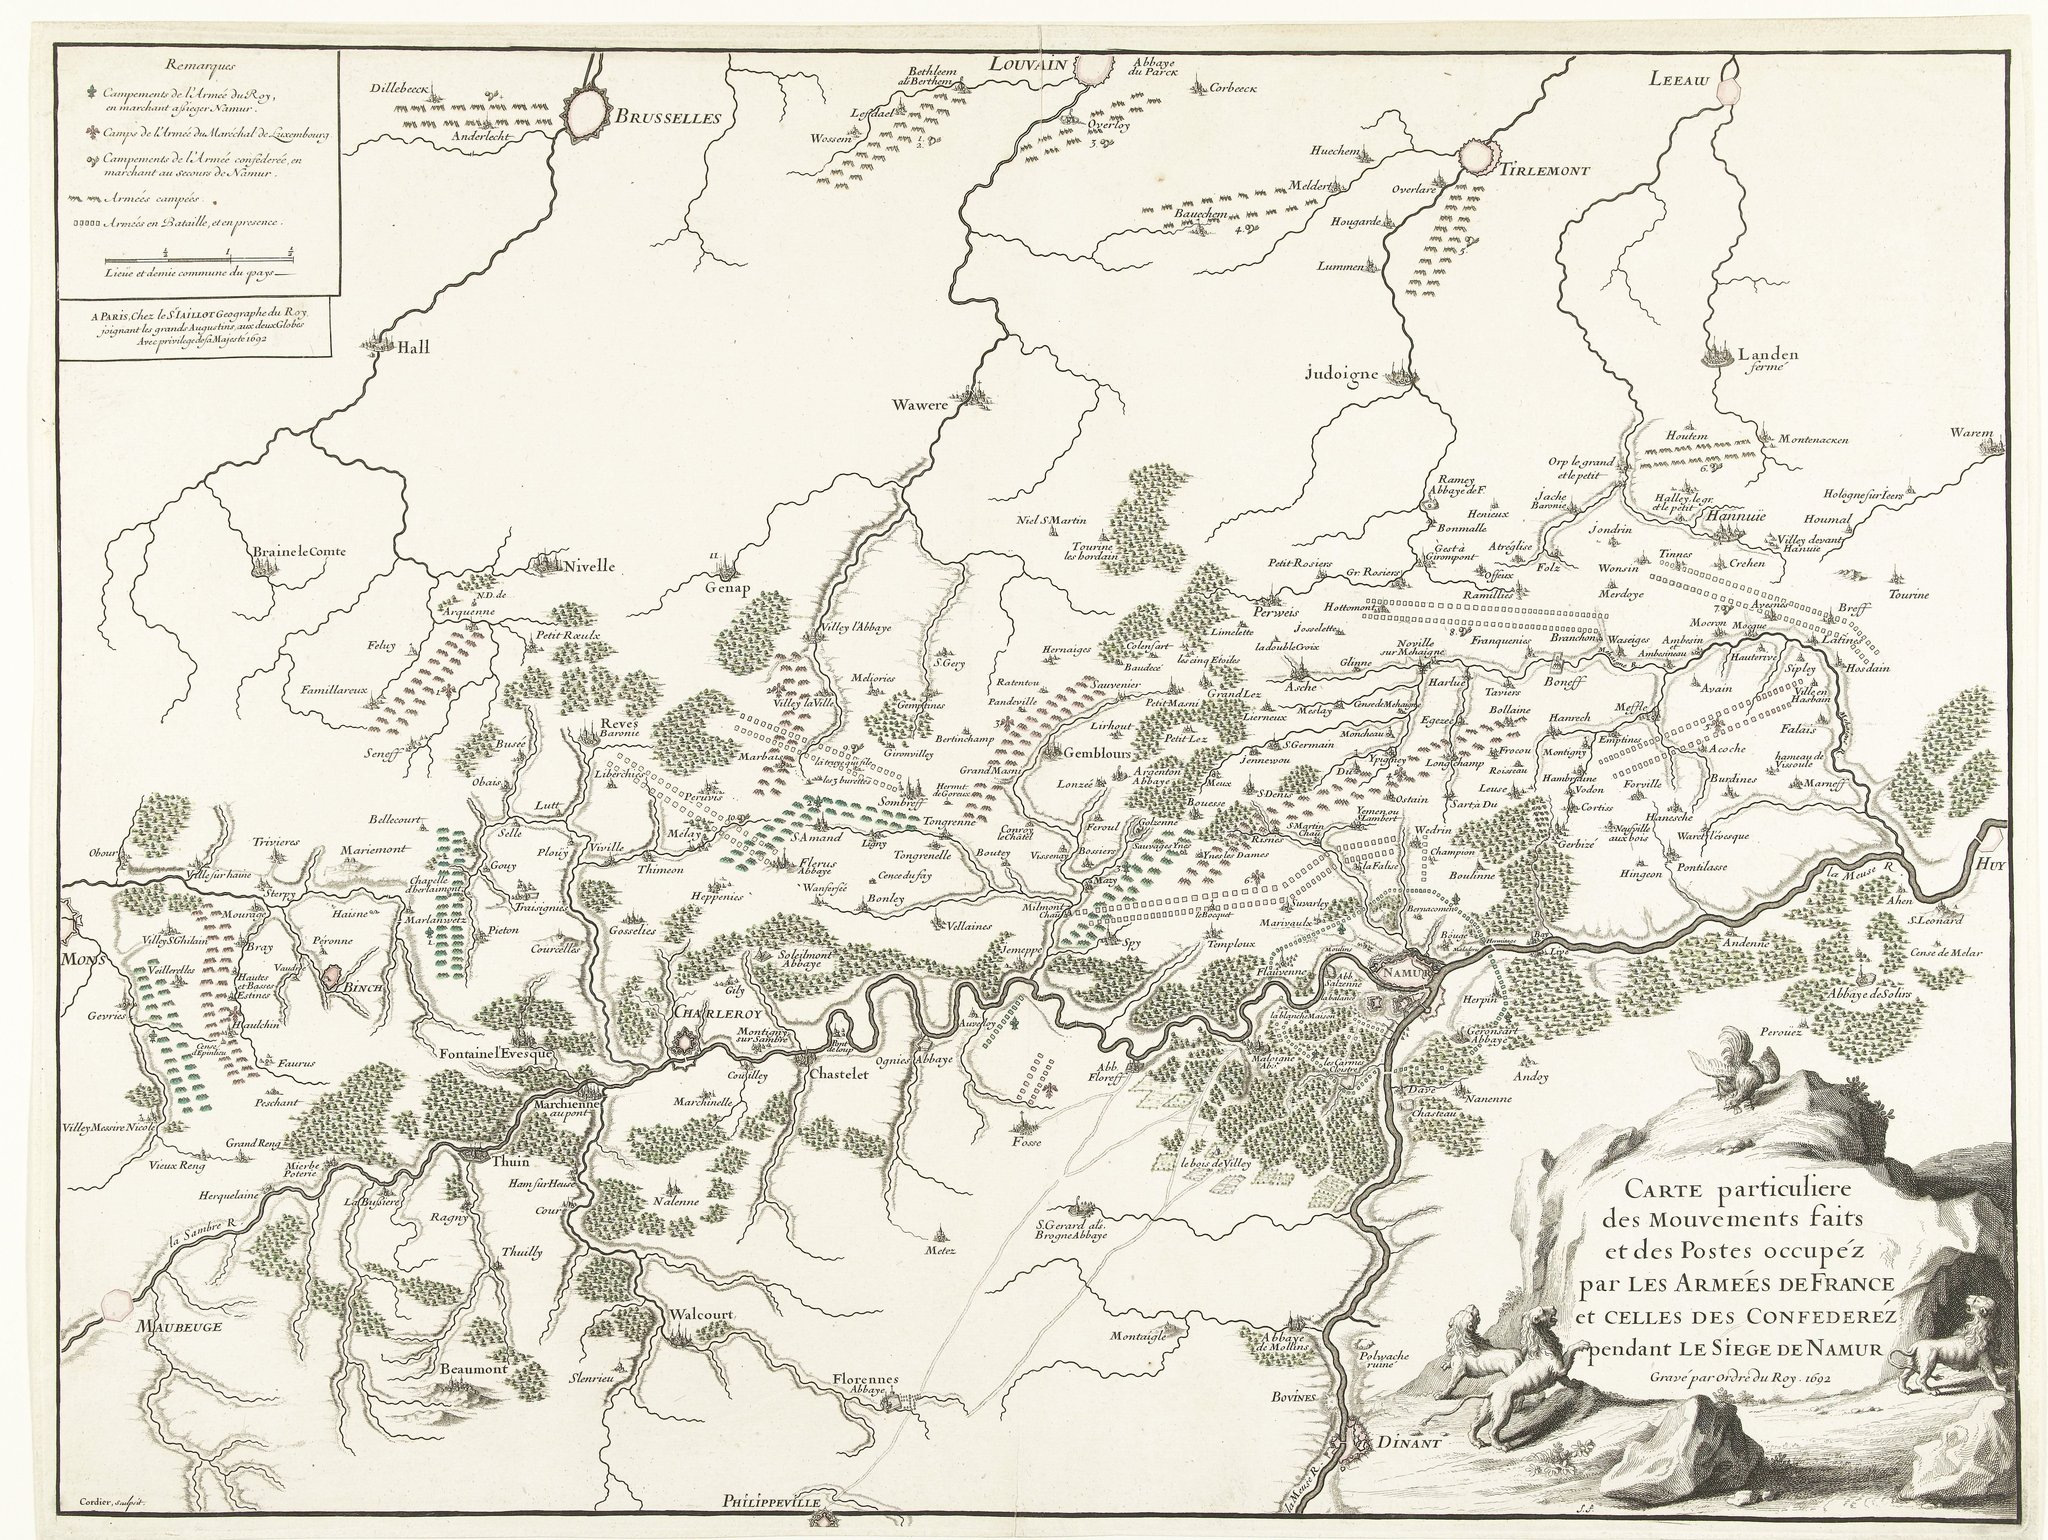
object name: map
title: Carte particuliere des Mouvements faits et des Postes occupéz par les Armées de France et celles des Confederez pendant Le Siege de Namur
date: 1692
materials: paper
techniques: etching, hand coloring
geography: paris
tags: siege, position war, maps of cities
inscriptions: date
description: Kaart van het gebied rond de stad Namen, belegerd door het Franse leger, 25 mei - 30 juni 1692. In de kaart de legerplaatsen van de verschillende legers. Rechtsonder een decoratie met een haan bovenop een berg die drie leeuwen beneden bespot.